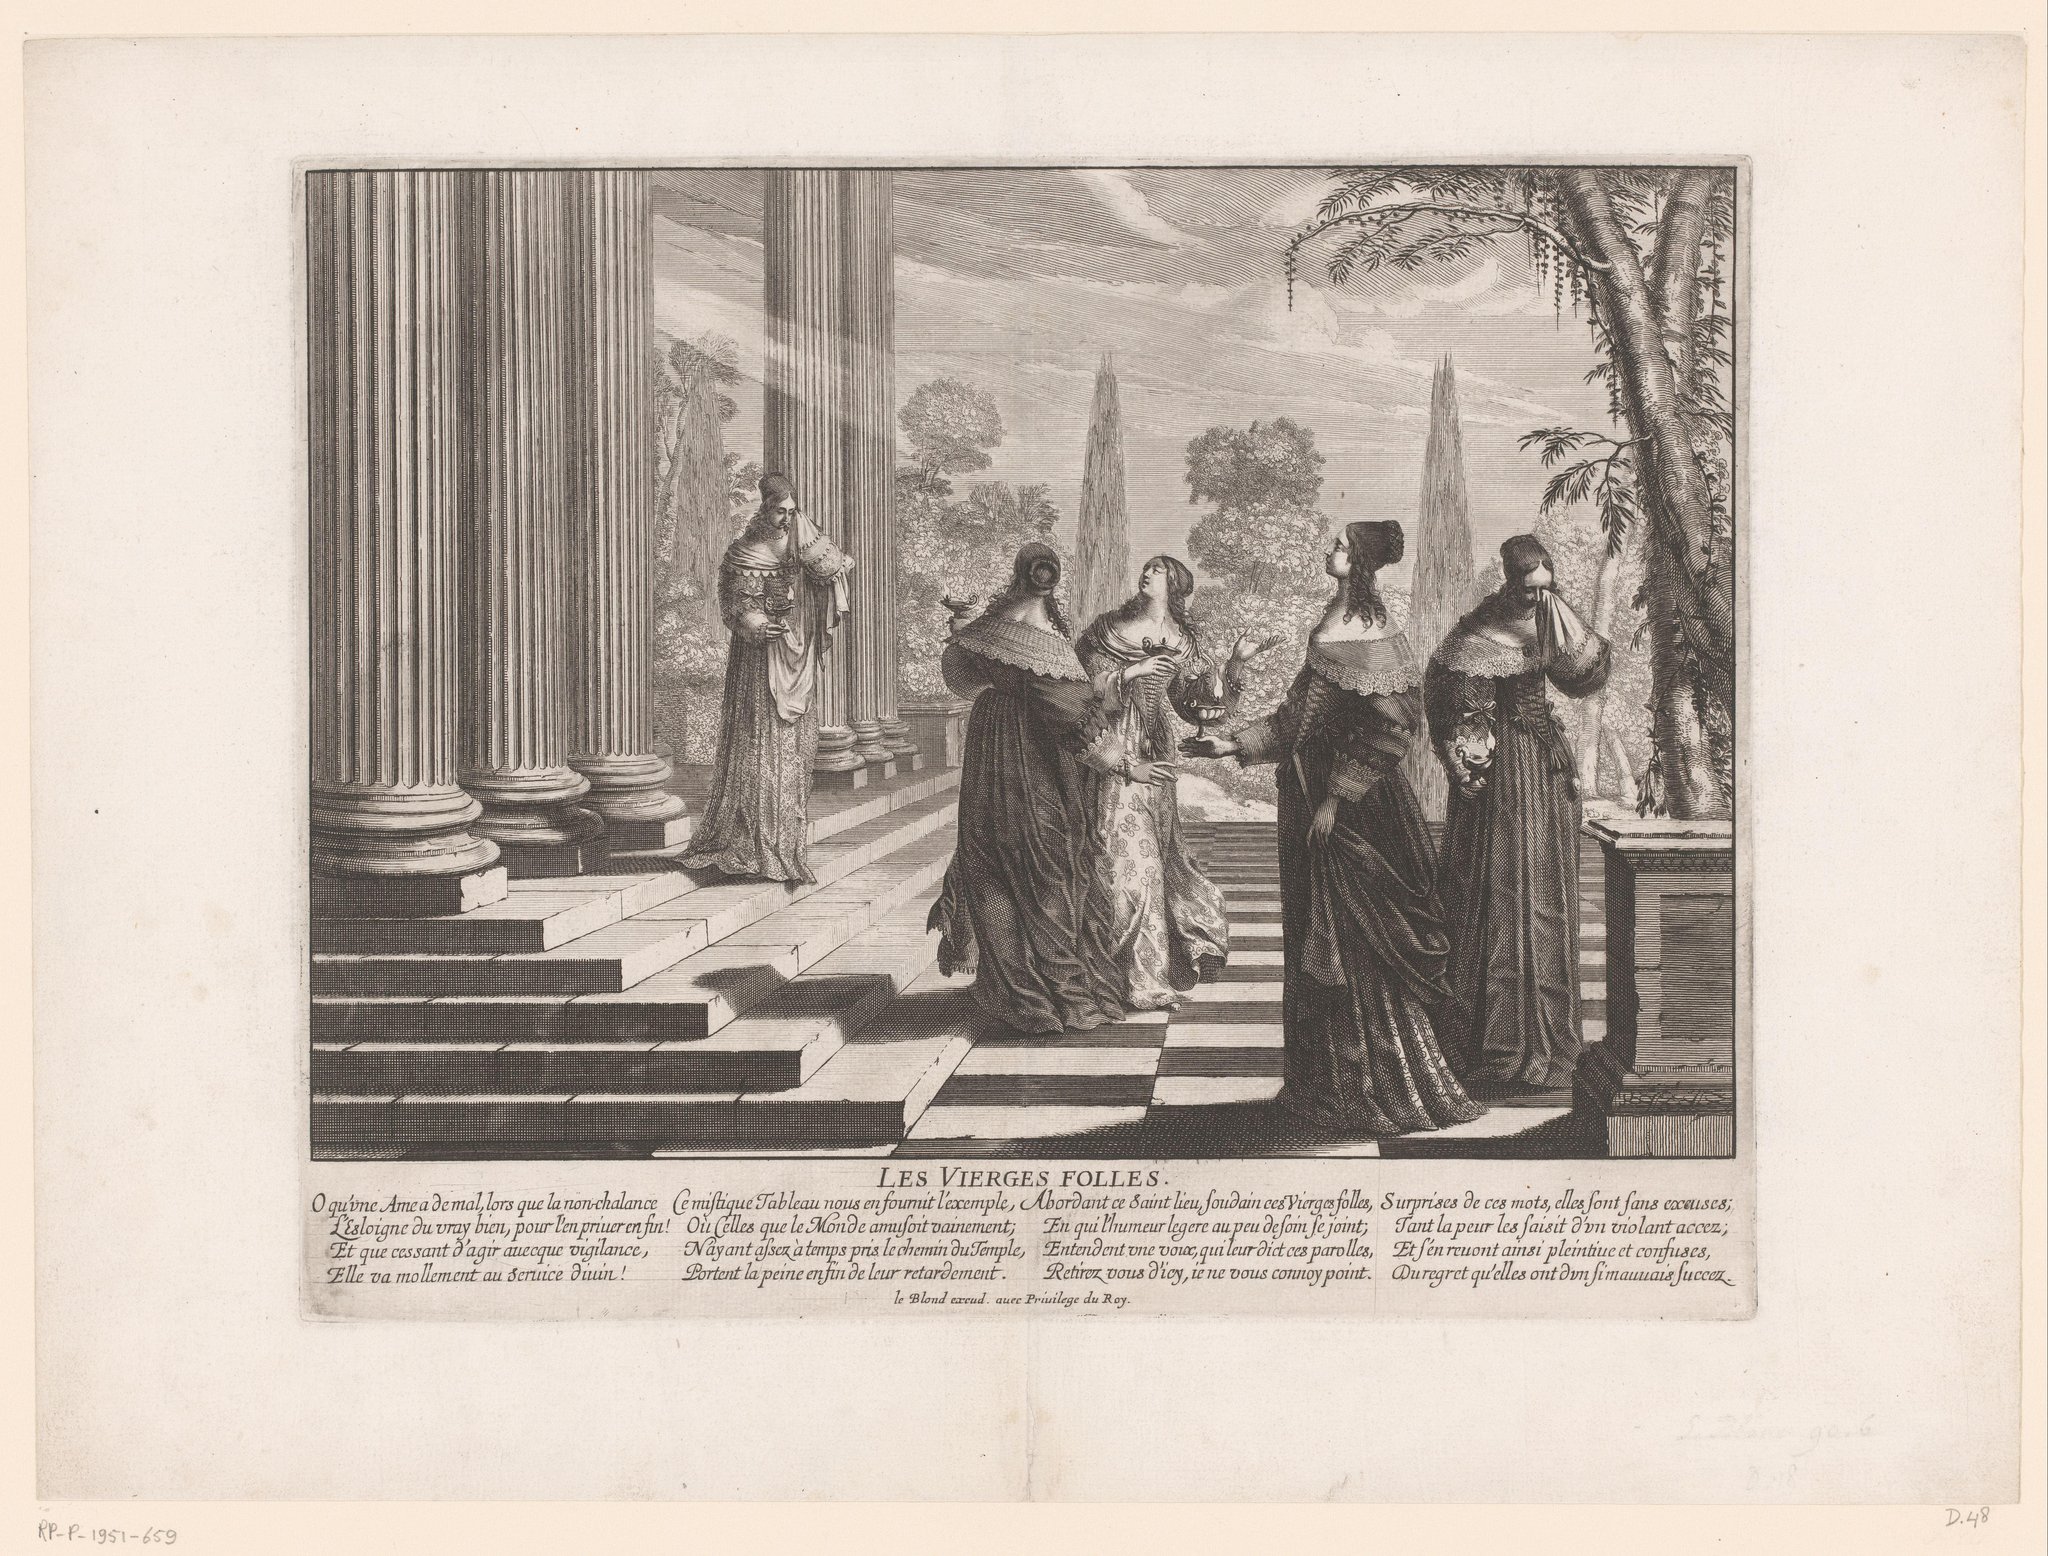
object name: print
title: Gelijkenis van de wijze en dwaze maagden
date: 1638-1640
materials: paper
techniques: engraving, etching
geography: paris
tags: the wise virgins are let into the house with the bridegroom (christ); the foolish virgins are shut out, the wise and the foolish virgins ~ parable of christ (matthew 25:1-13), oil-lamp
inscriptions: collector's mark: Lugt 2228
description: Maakt deel uit van een serie van zeven prenten met als onderwerp de parabel van de vijf wijze en de vijf dwaze maagden. De eerste staat werd uitgegeven door Jean Leblond (I) en een tweede staat door de weduwe van Poilly.